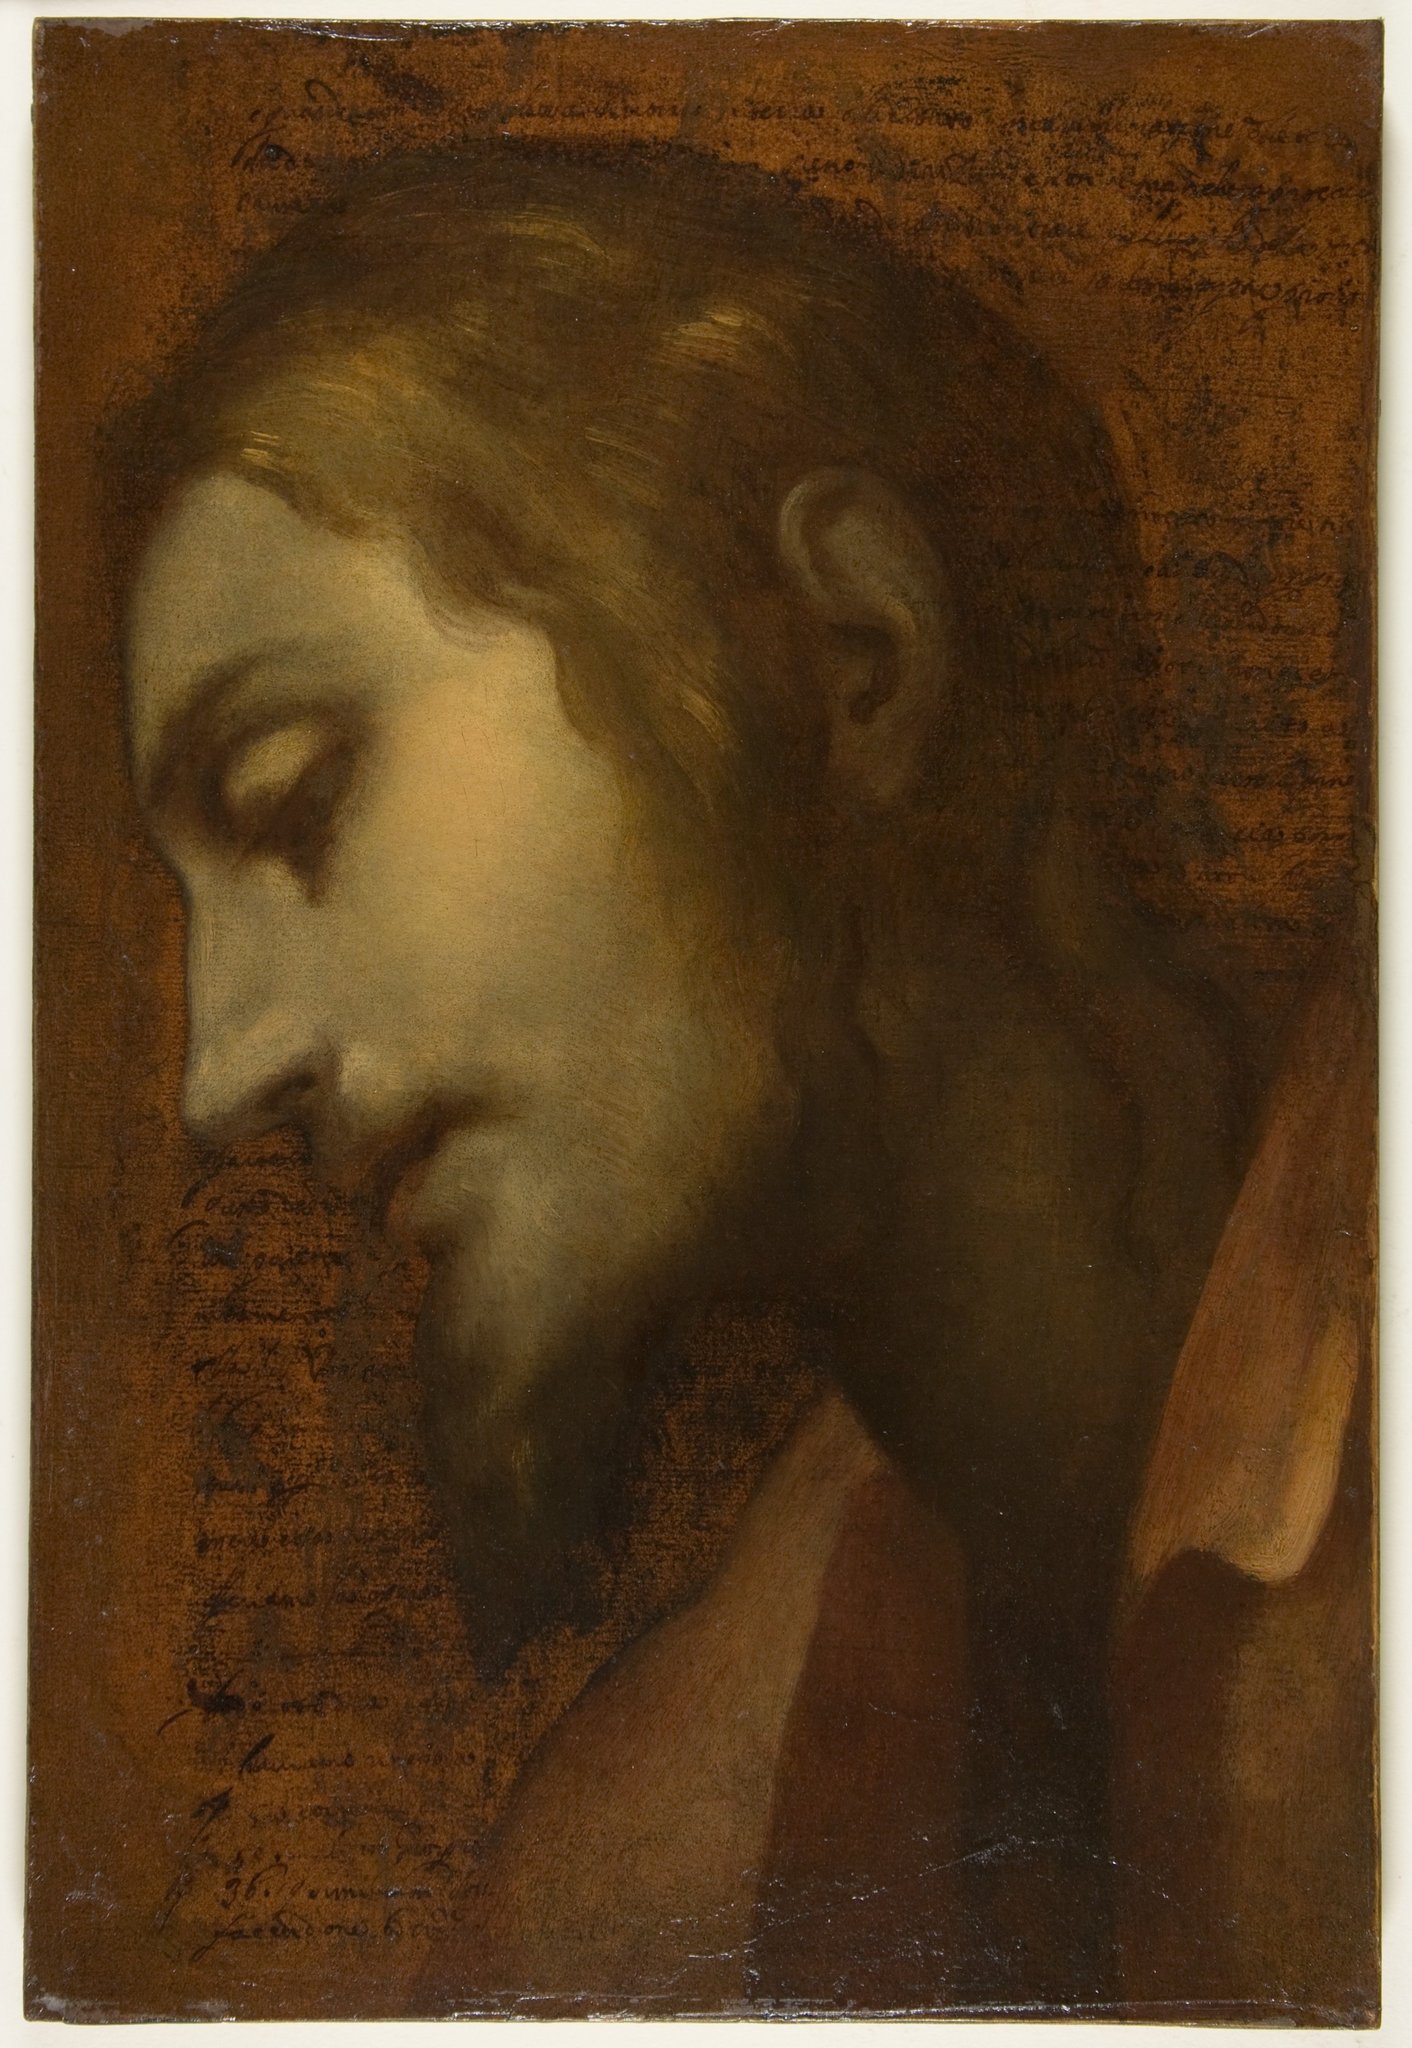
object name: drawing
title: Head of Christ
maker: cigoli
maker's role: artist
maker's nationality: italian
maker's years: 1559-1613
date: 1559-1613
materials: ink, oil, paper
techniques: pen, writing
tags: christ